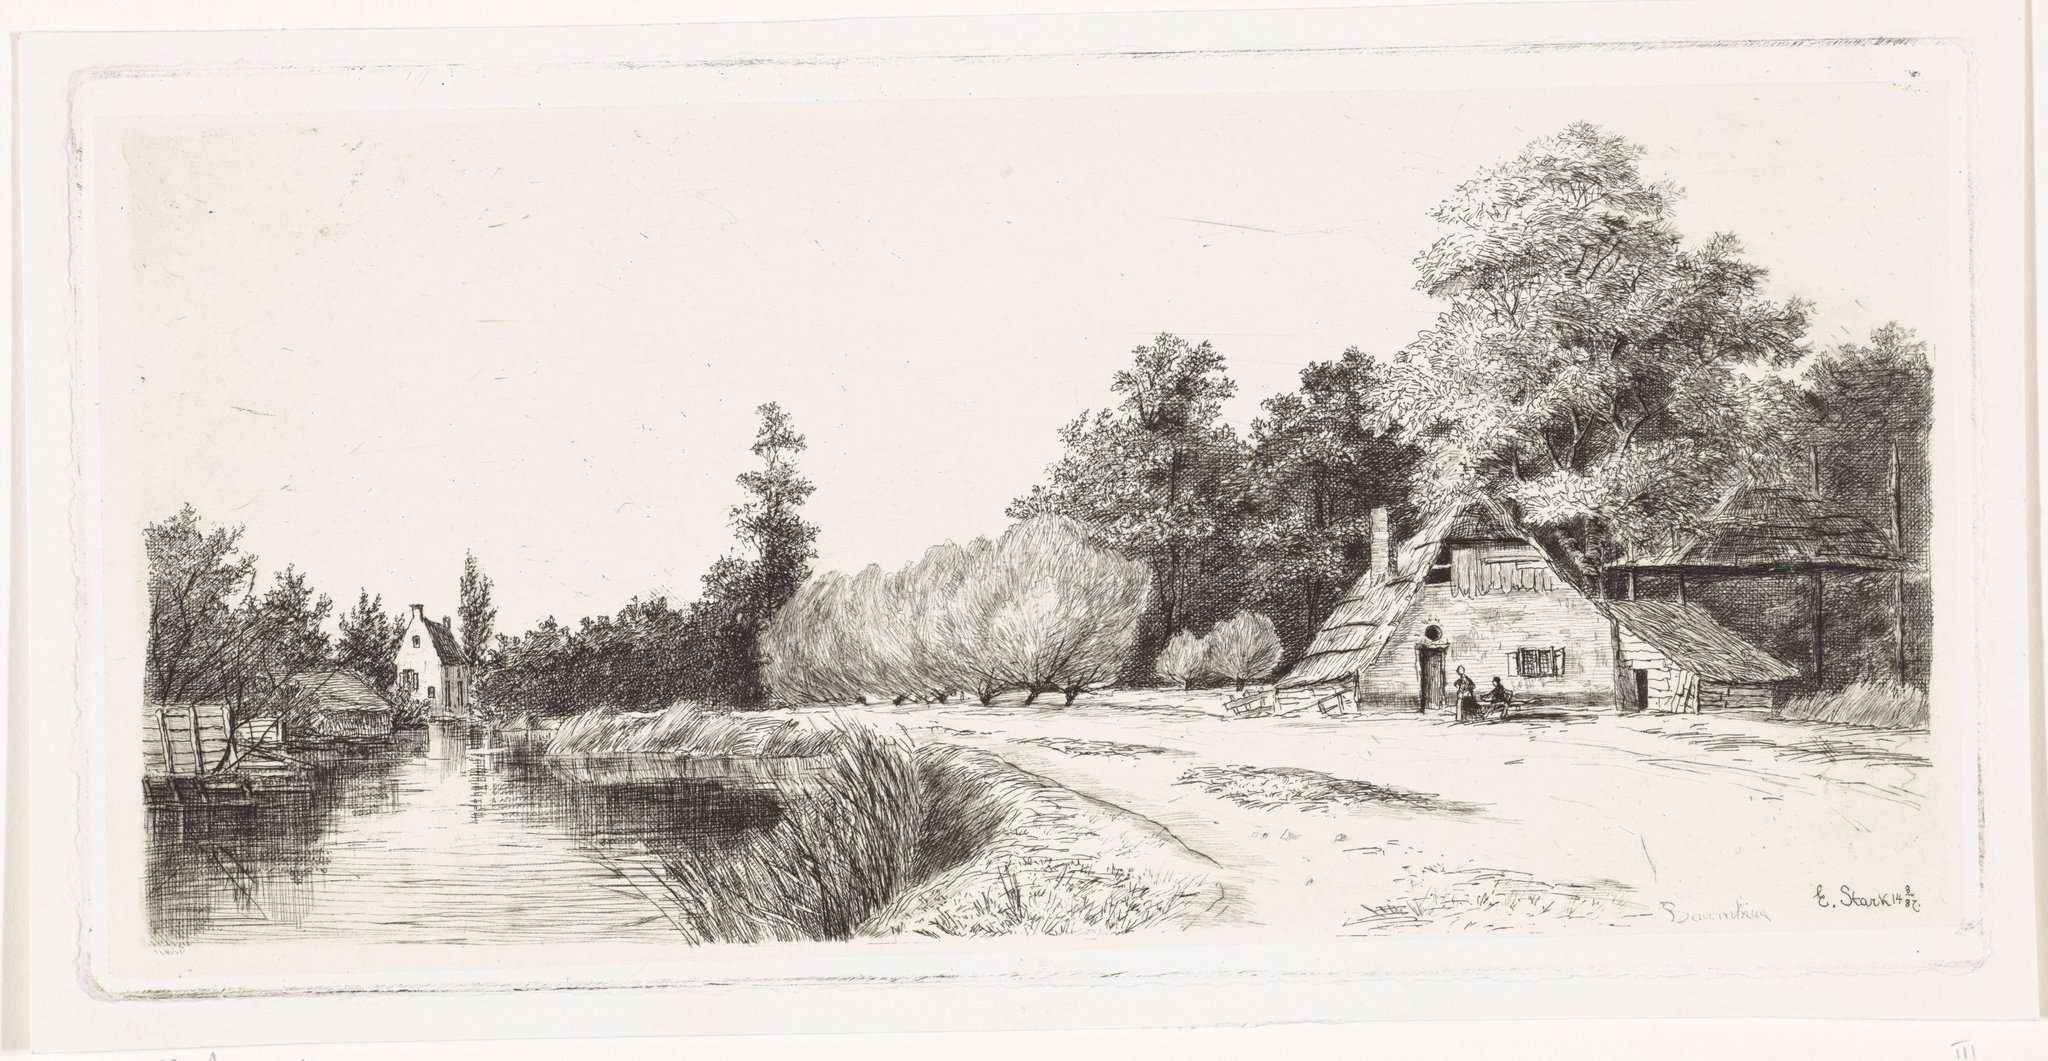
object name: print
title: Landschap bij Baambrugge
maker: elias stark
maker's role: draughtsman, print maker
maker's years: 1849-1933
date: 1887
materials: paper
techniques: drypoint, etching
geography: nieuwer-amstel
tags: river, farm or solitary house in landscape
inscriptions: collector's mark: Lugt 2228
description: Huizen langs het riviertje de Angstel in Baambrugge. Achter de boerderij een hooiberg.